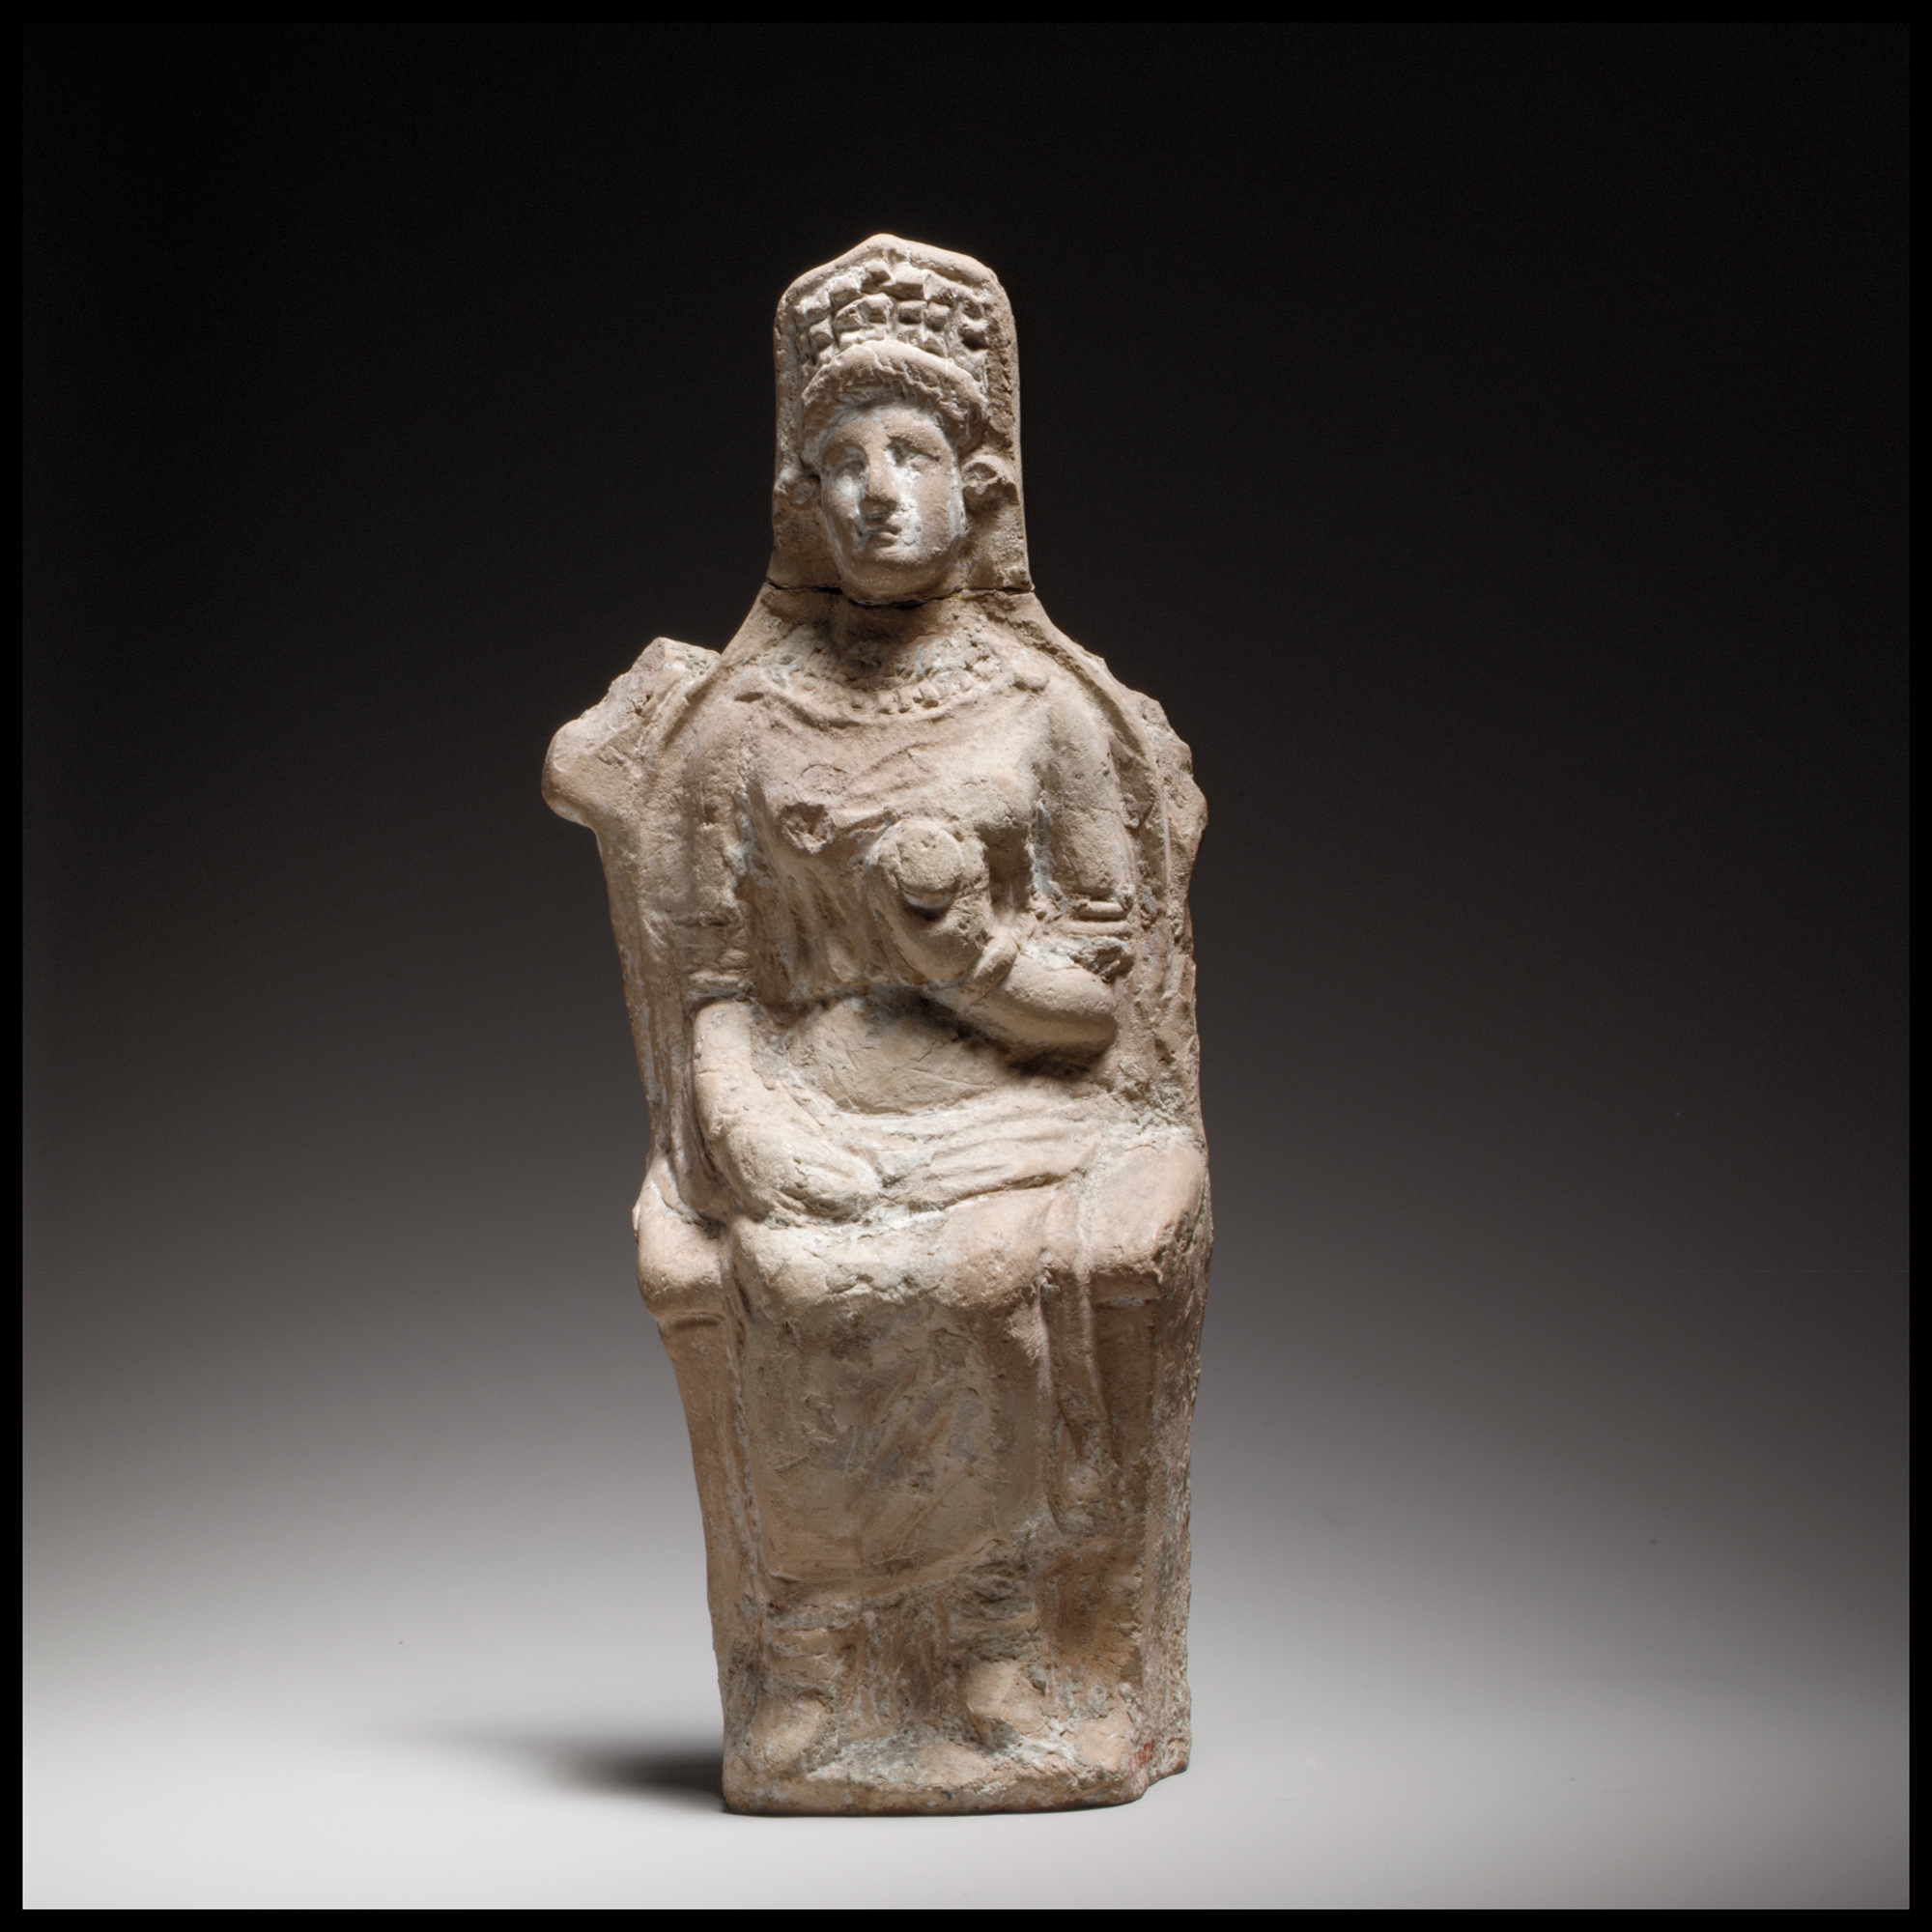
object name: figurine of a seated goddess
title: Terracotta figurine of a seated goddess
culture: cypriot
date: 300-201 BCE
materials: terracotta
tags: goddess